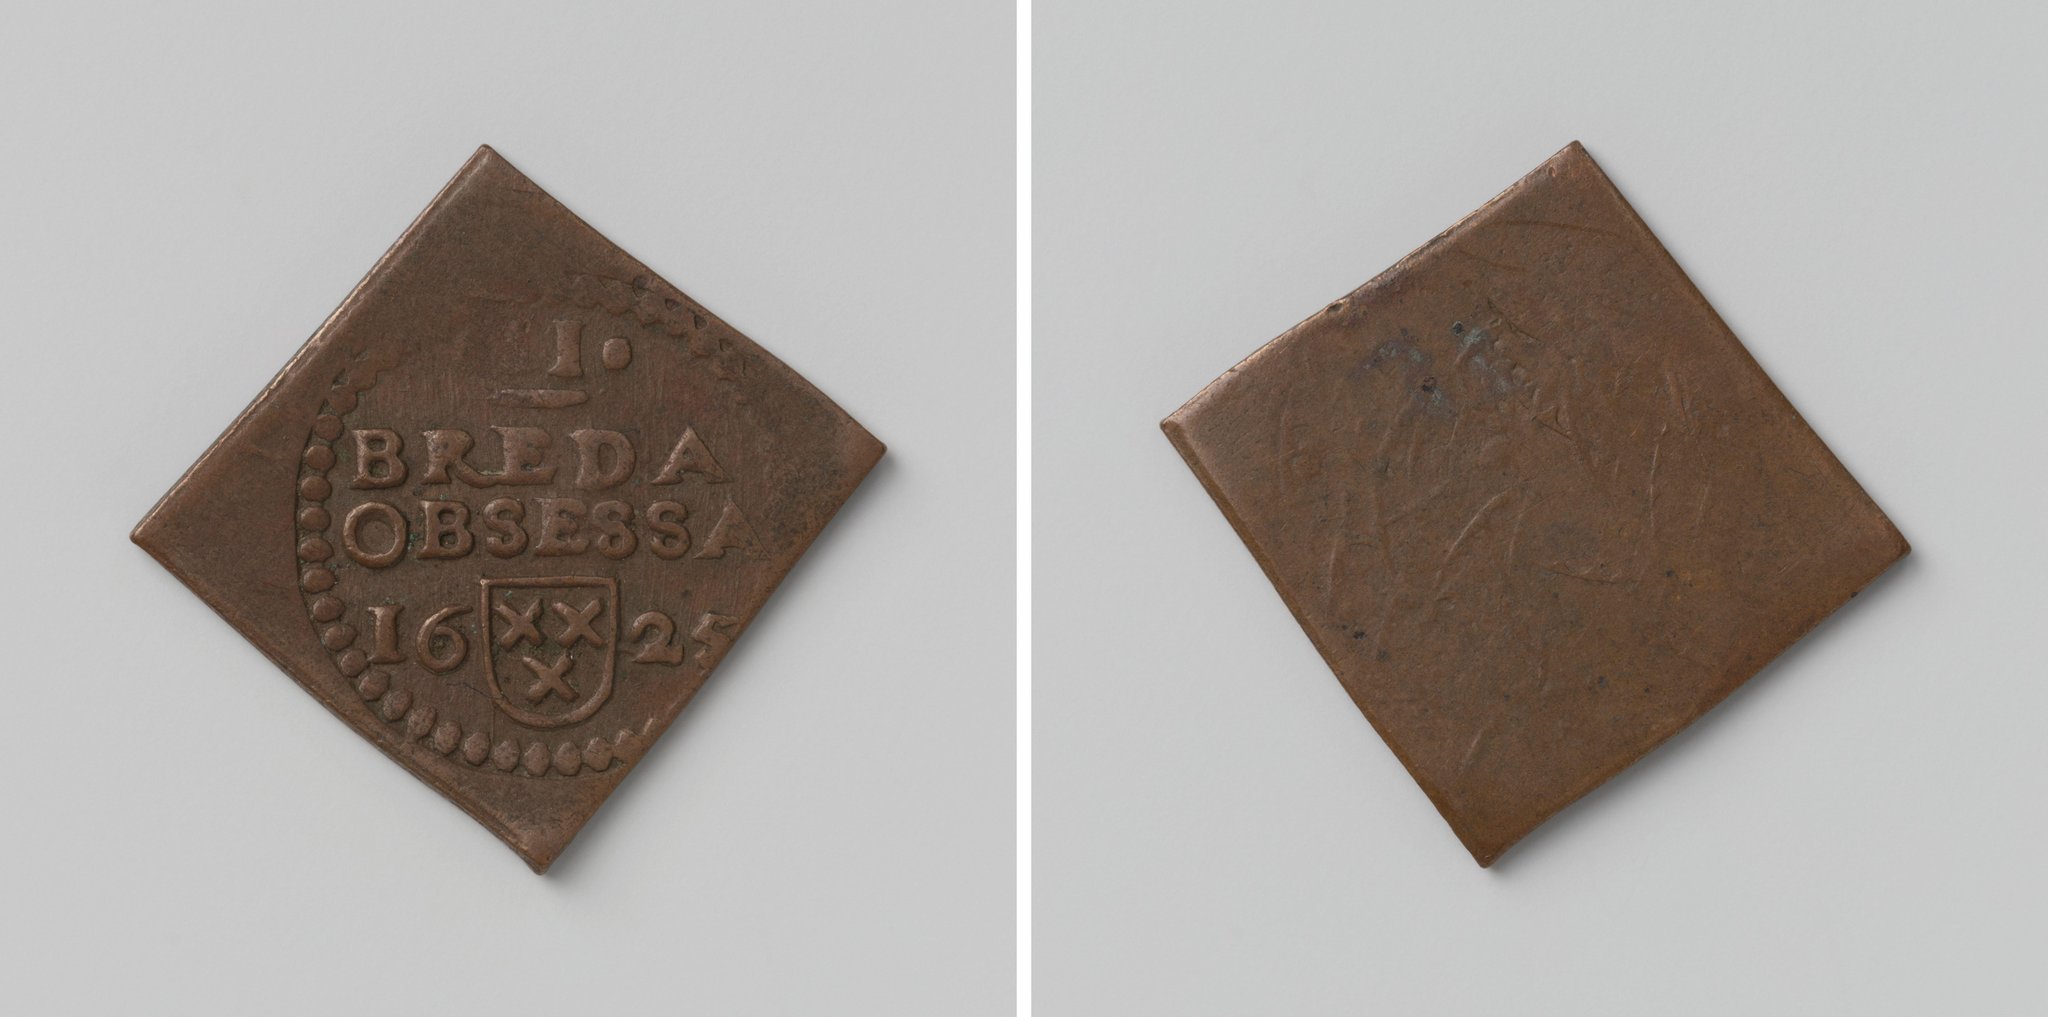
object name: dubbele stuiver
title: dubbele stuiver, noodmunt uit Breda, geslagen tijdens het beleg door Spinola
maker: Anonymous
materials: copper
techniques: striking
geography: breda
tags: genua, castelnuovo scrivia, veldheer, ambrogio spinola (markies de los balbases), breda, inname van breda (1625), tachtigjarige oorlog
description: enkelzijdige, ruitvormige noodmunt van Breda. Voorzijde: een stempel in ronde parelrand: opschrift boven jaartal, onderbroken door wapenschild. Keerzijde: blanco